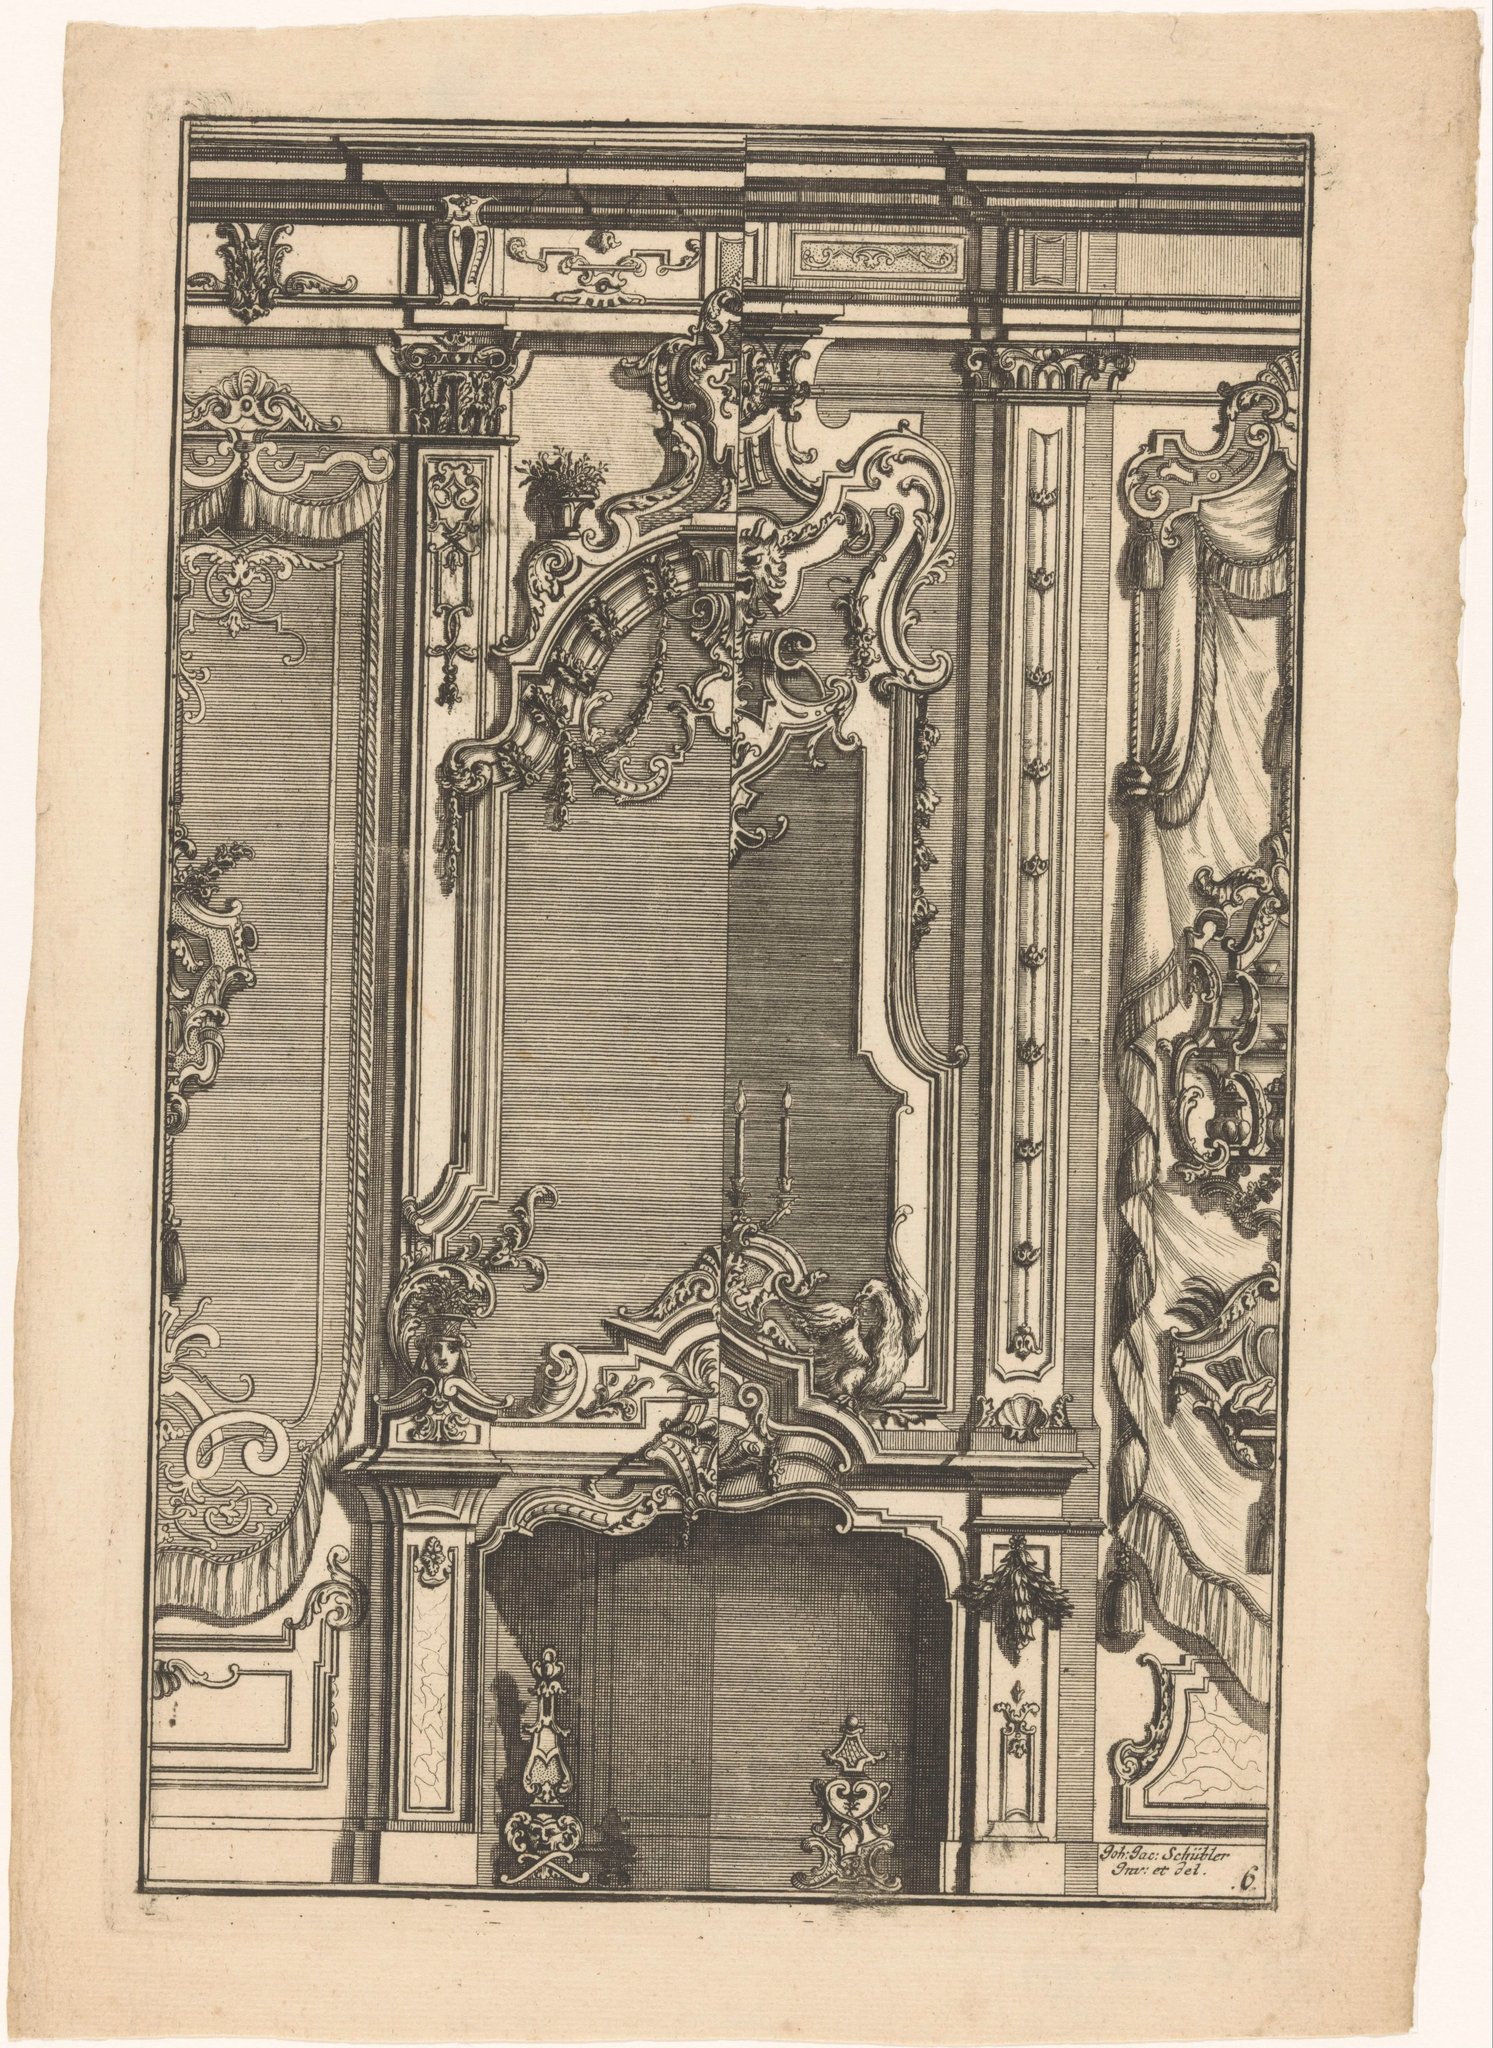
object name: ornament print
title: Nouveau Livre des Chemines (...)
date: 1699-1726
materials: paper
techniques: engraving, etching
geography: nuremberg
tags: predatory birds: eagle, chandelier, candelabrum, open hearth, fire-place, (dinner-)service displayed on sideboard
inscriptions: collector's mark: Lugt 2228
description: Een schouw met rocaille ornamenten, vlechtwerk, een adelaar rechts, een kandelaar in het midden, guirlandes en bloemenmanden. Rechts is de helft van een meubel met servies en draperieën zichtbaar.